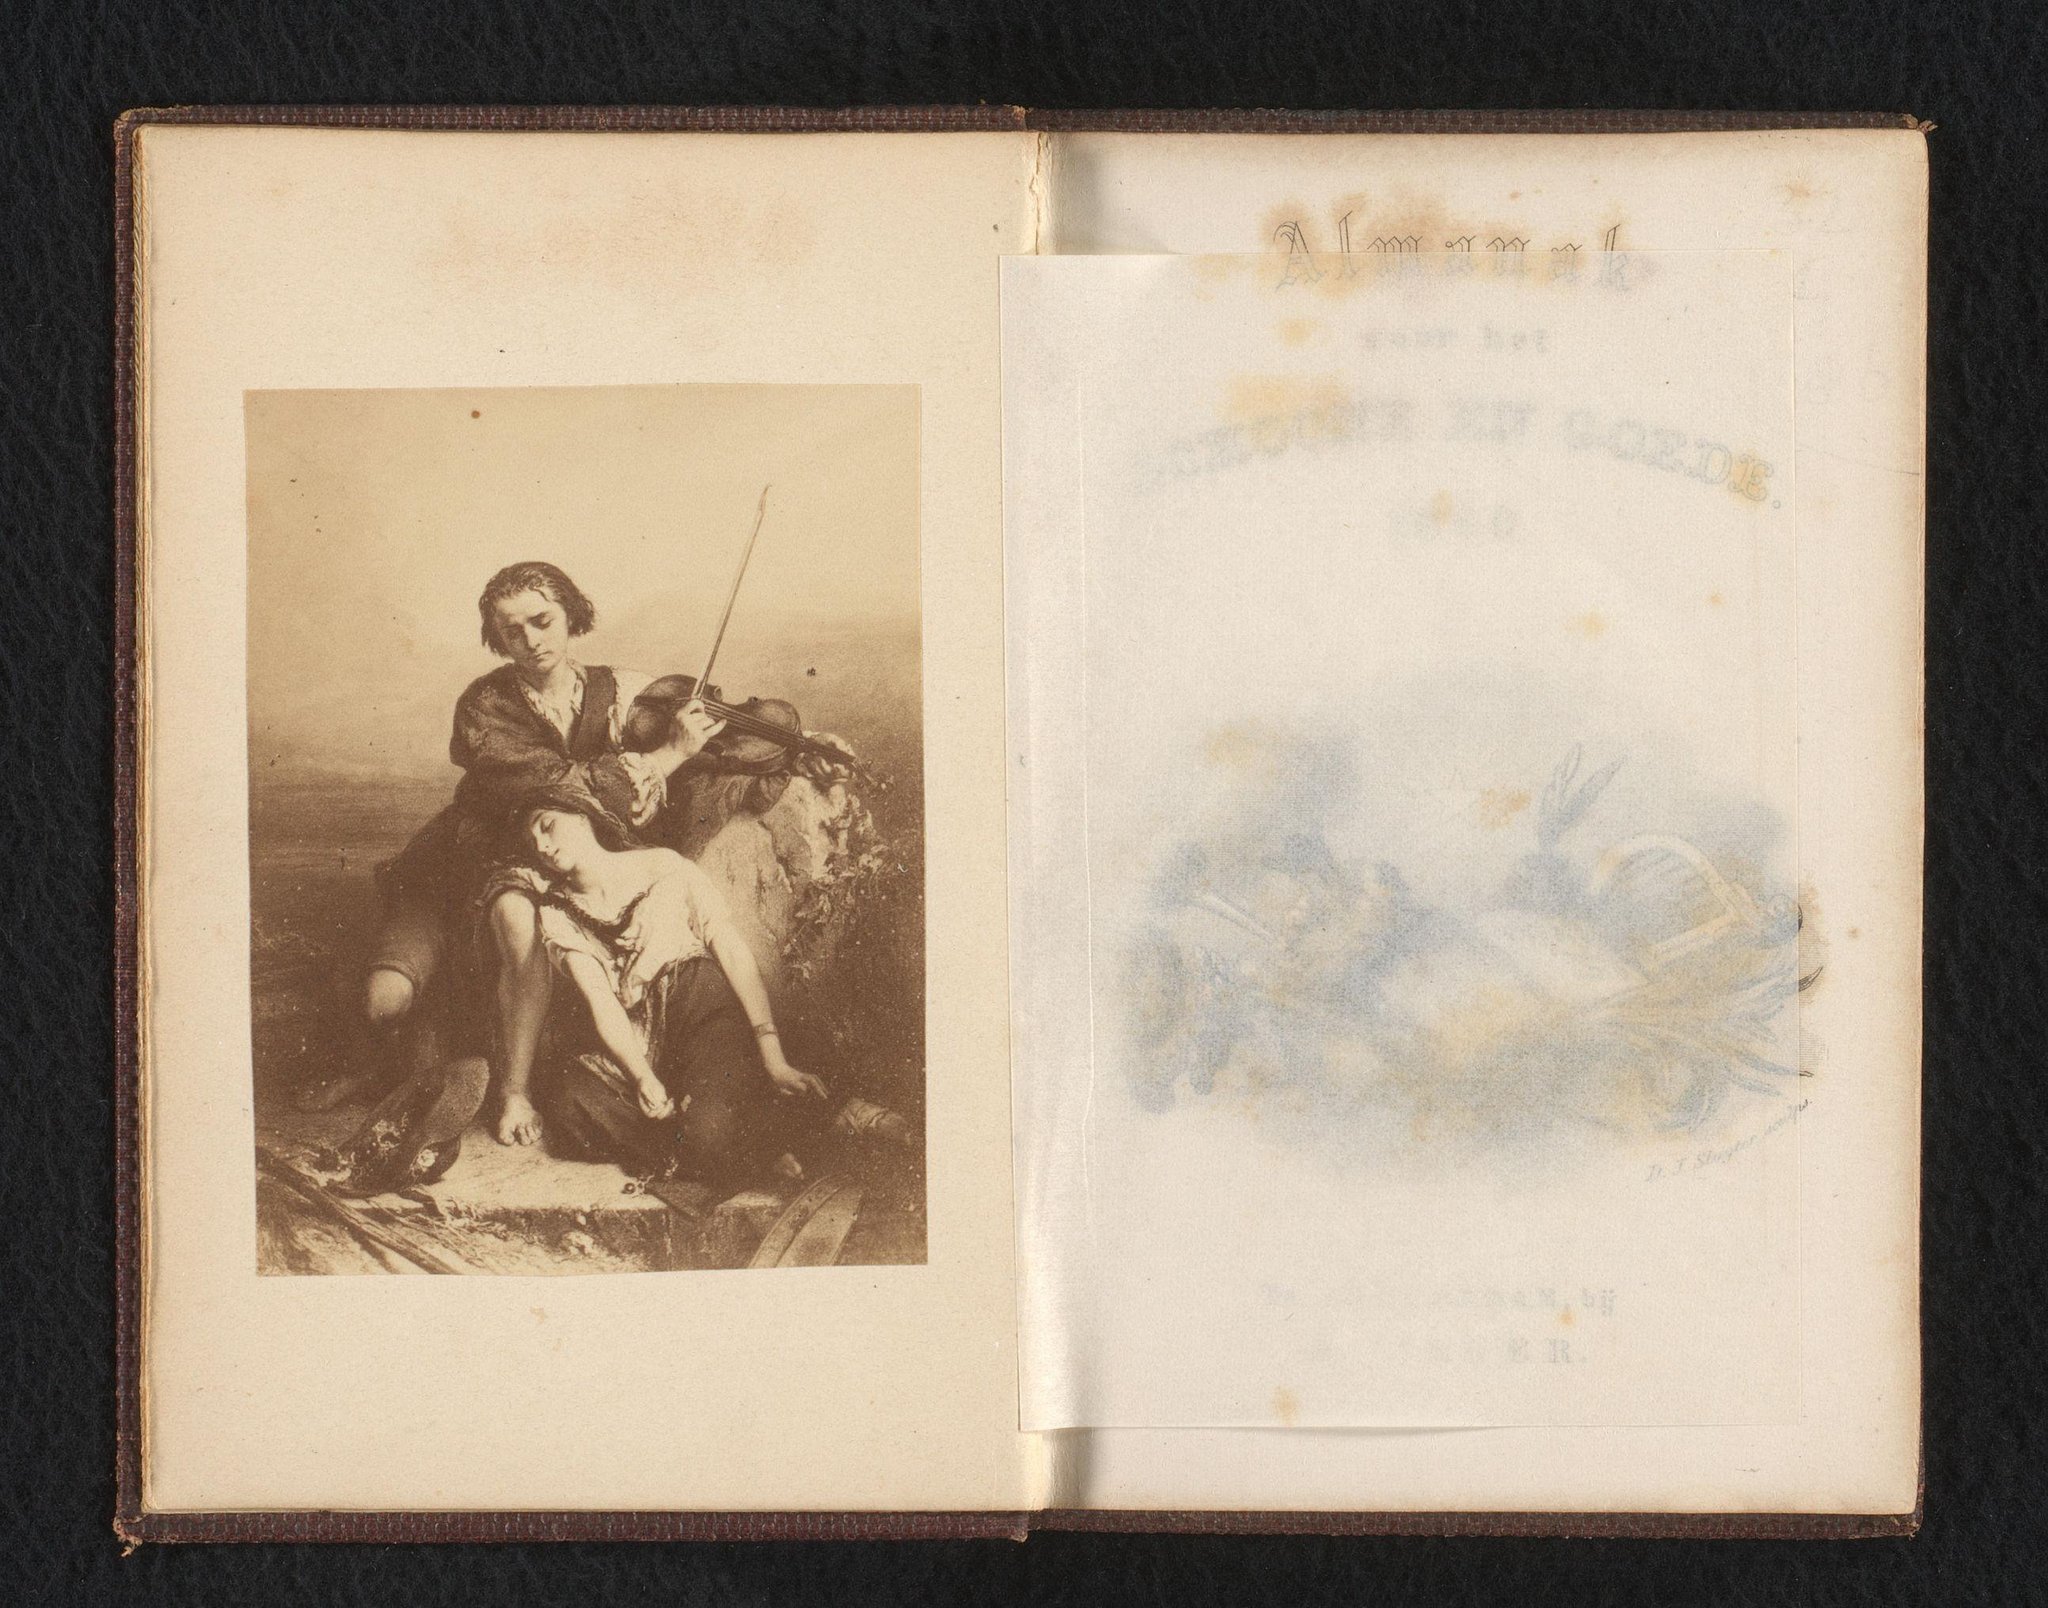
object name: page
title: Fotoreproductie van een schilderij van een vioolspelende jongen met meisje aan zijn voeten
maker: Anonymous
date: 1855-1860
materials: paper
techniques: albumen print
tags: musician - cc - out of doors, violin, fiddle - cc - out of doors